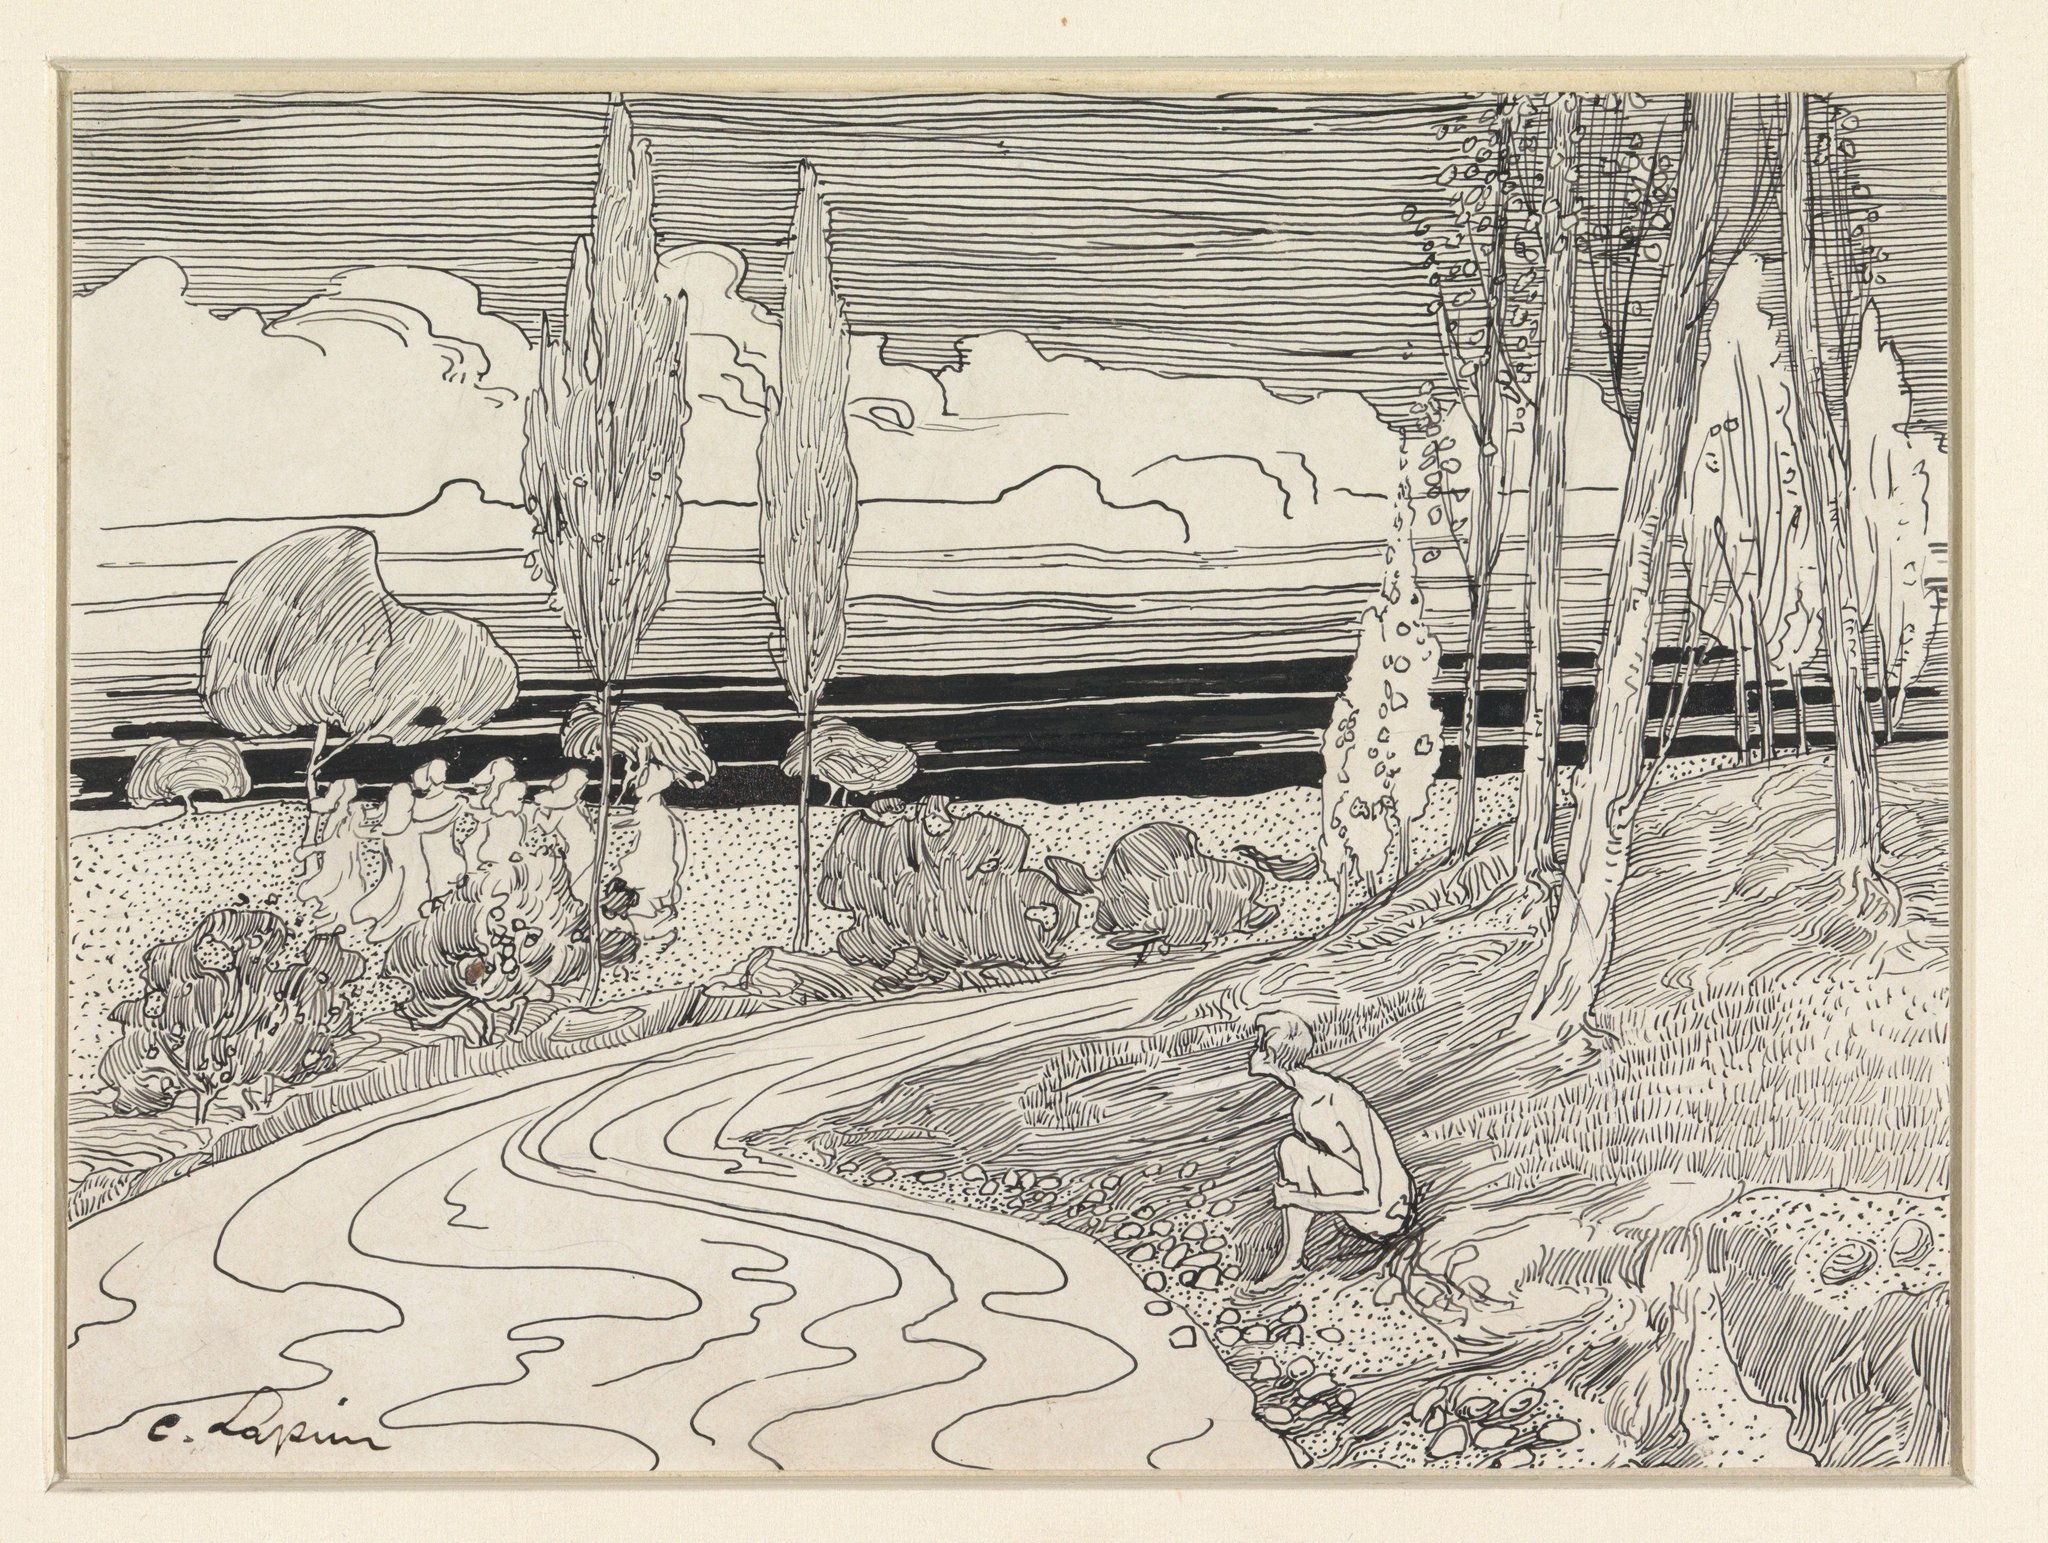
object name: drawing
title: Dansende vrouwen in landschap; een jongen zit langs de kant van de weg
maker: c. lapine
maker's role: draughtsman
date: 1895-1900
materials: ink, paper, pencil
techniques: brush, pen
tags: landscapes in the temperate zone, group of women (folk dancing)